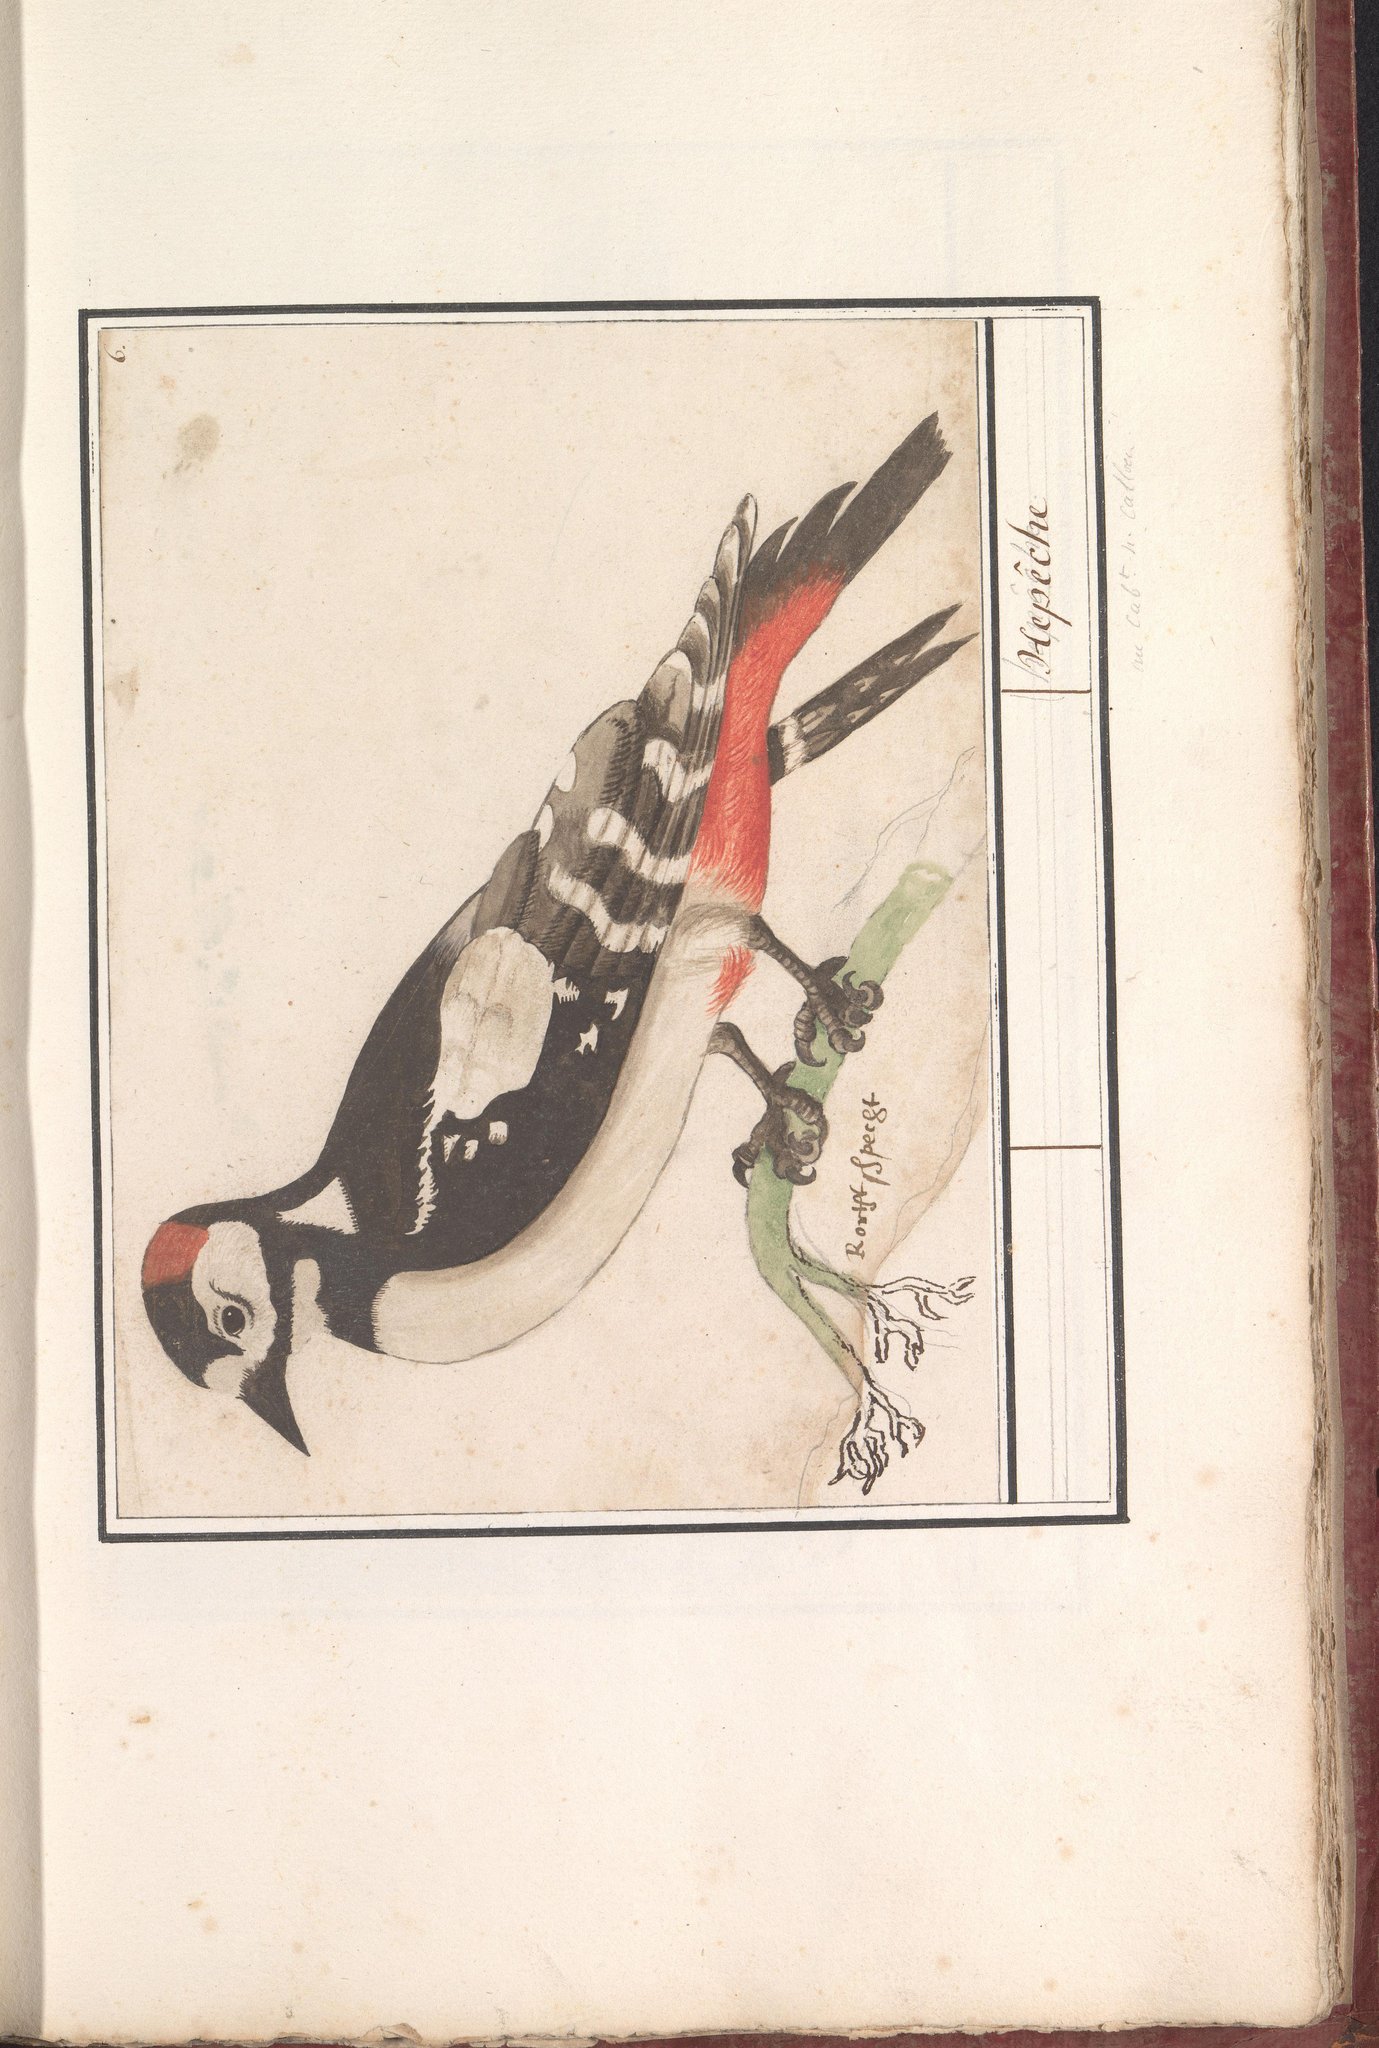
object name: drawing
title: Great Spotted Woodpecker (Dendrocopos major)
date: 1596-1610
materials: paint, ink, paper, pencil, watercolor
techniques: brush, pen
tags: other birds: woodpecker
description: De Boodt probably compiled his ‘three large albums’ as follows: one for plants, one for animals, and one for birds. The bird album was damaged, which may explain why all the drawings were rebound in the early 19th century. Only the branch, on which this great spotted woodpecker perches, was affected. The bird itself – identified by the red spot on its head as a male – was left unscathed.